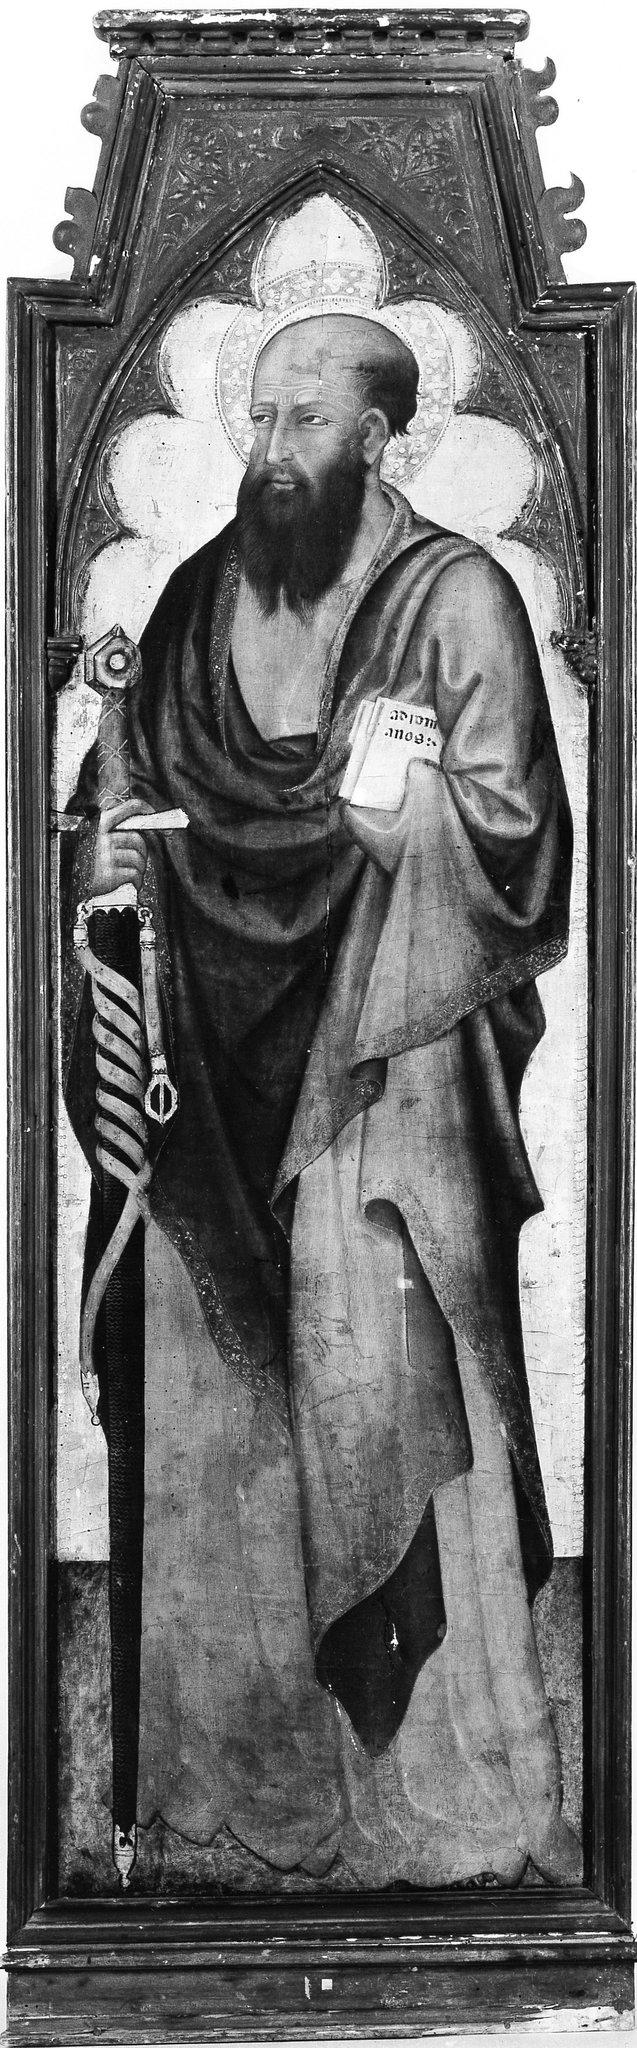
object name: painting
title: Saint Paul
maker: niccolò di buonaccorso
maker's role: artist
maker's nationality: italian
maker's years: 1372-1388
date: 1372-1388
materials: gold leaf, paint, wood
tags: men,saint paul